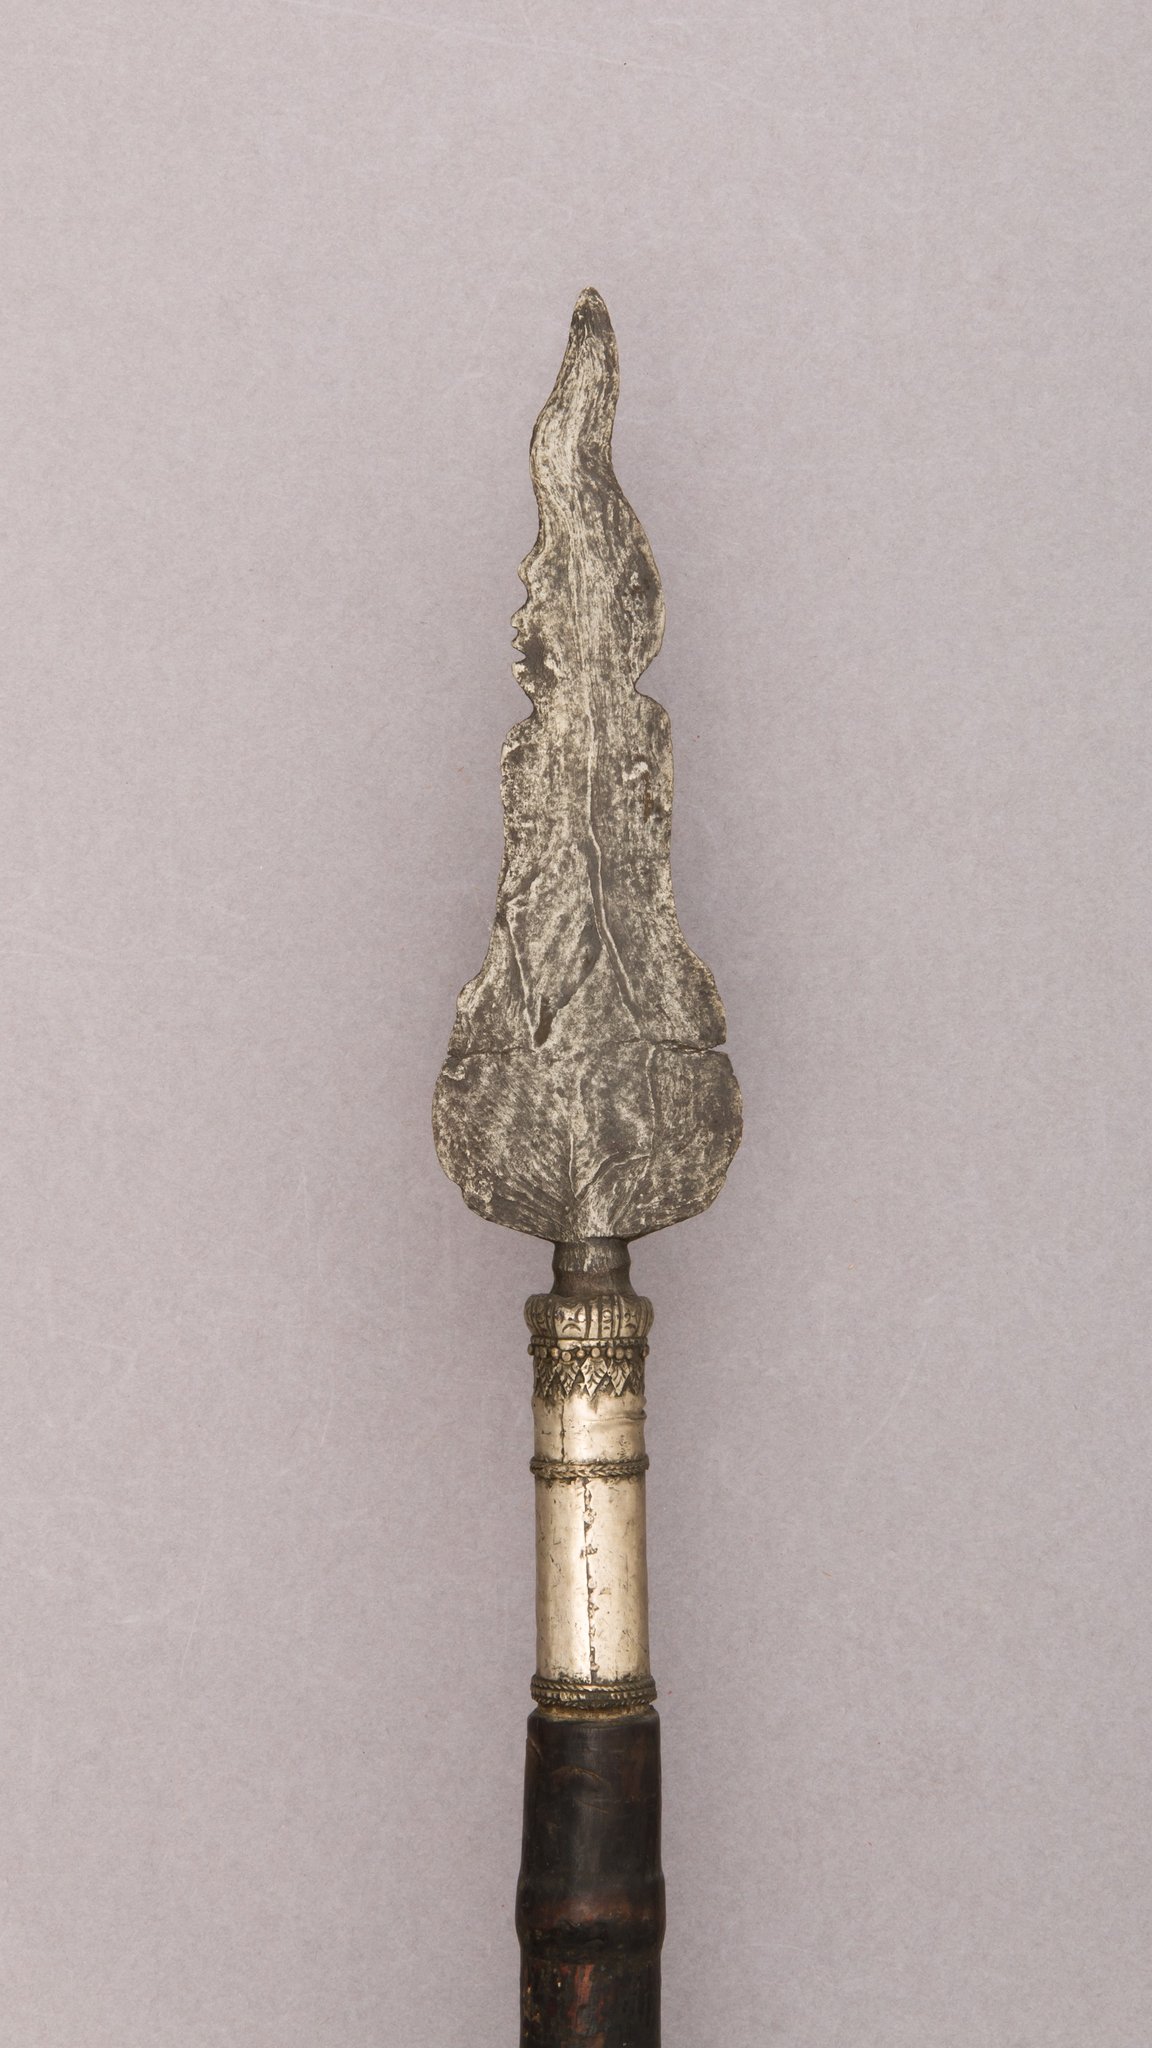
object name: spear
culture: javanese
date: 1501-1900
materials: bamboo, silver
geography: indonesia